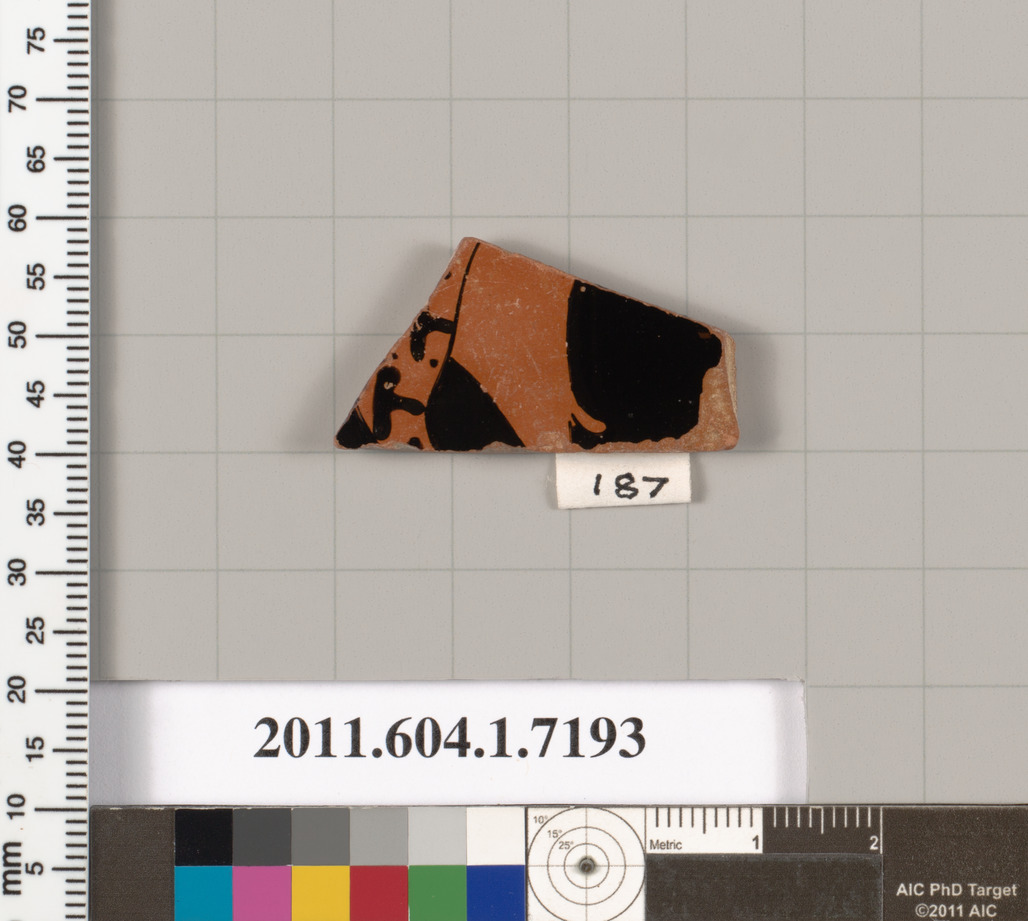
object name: kylix fragment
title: Terracotta fragment of a kylix (drinking cup)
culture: greek, attic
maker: makron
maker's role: artist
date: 500-480 BCE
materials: terracotta